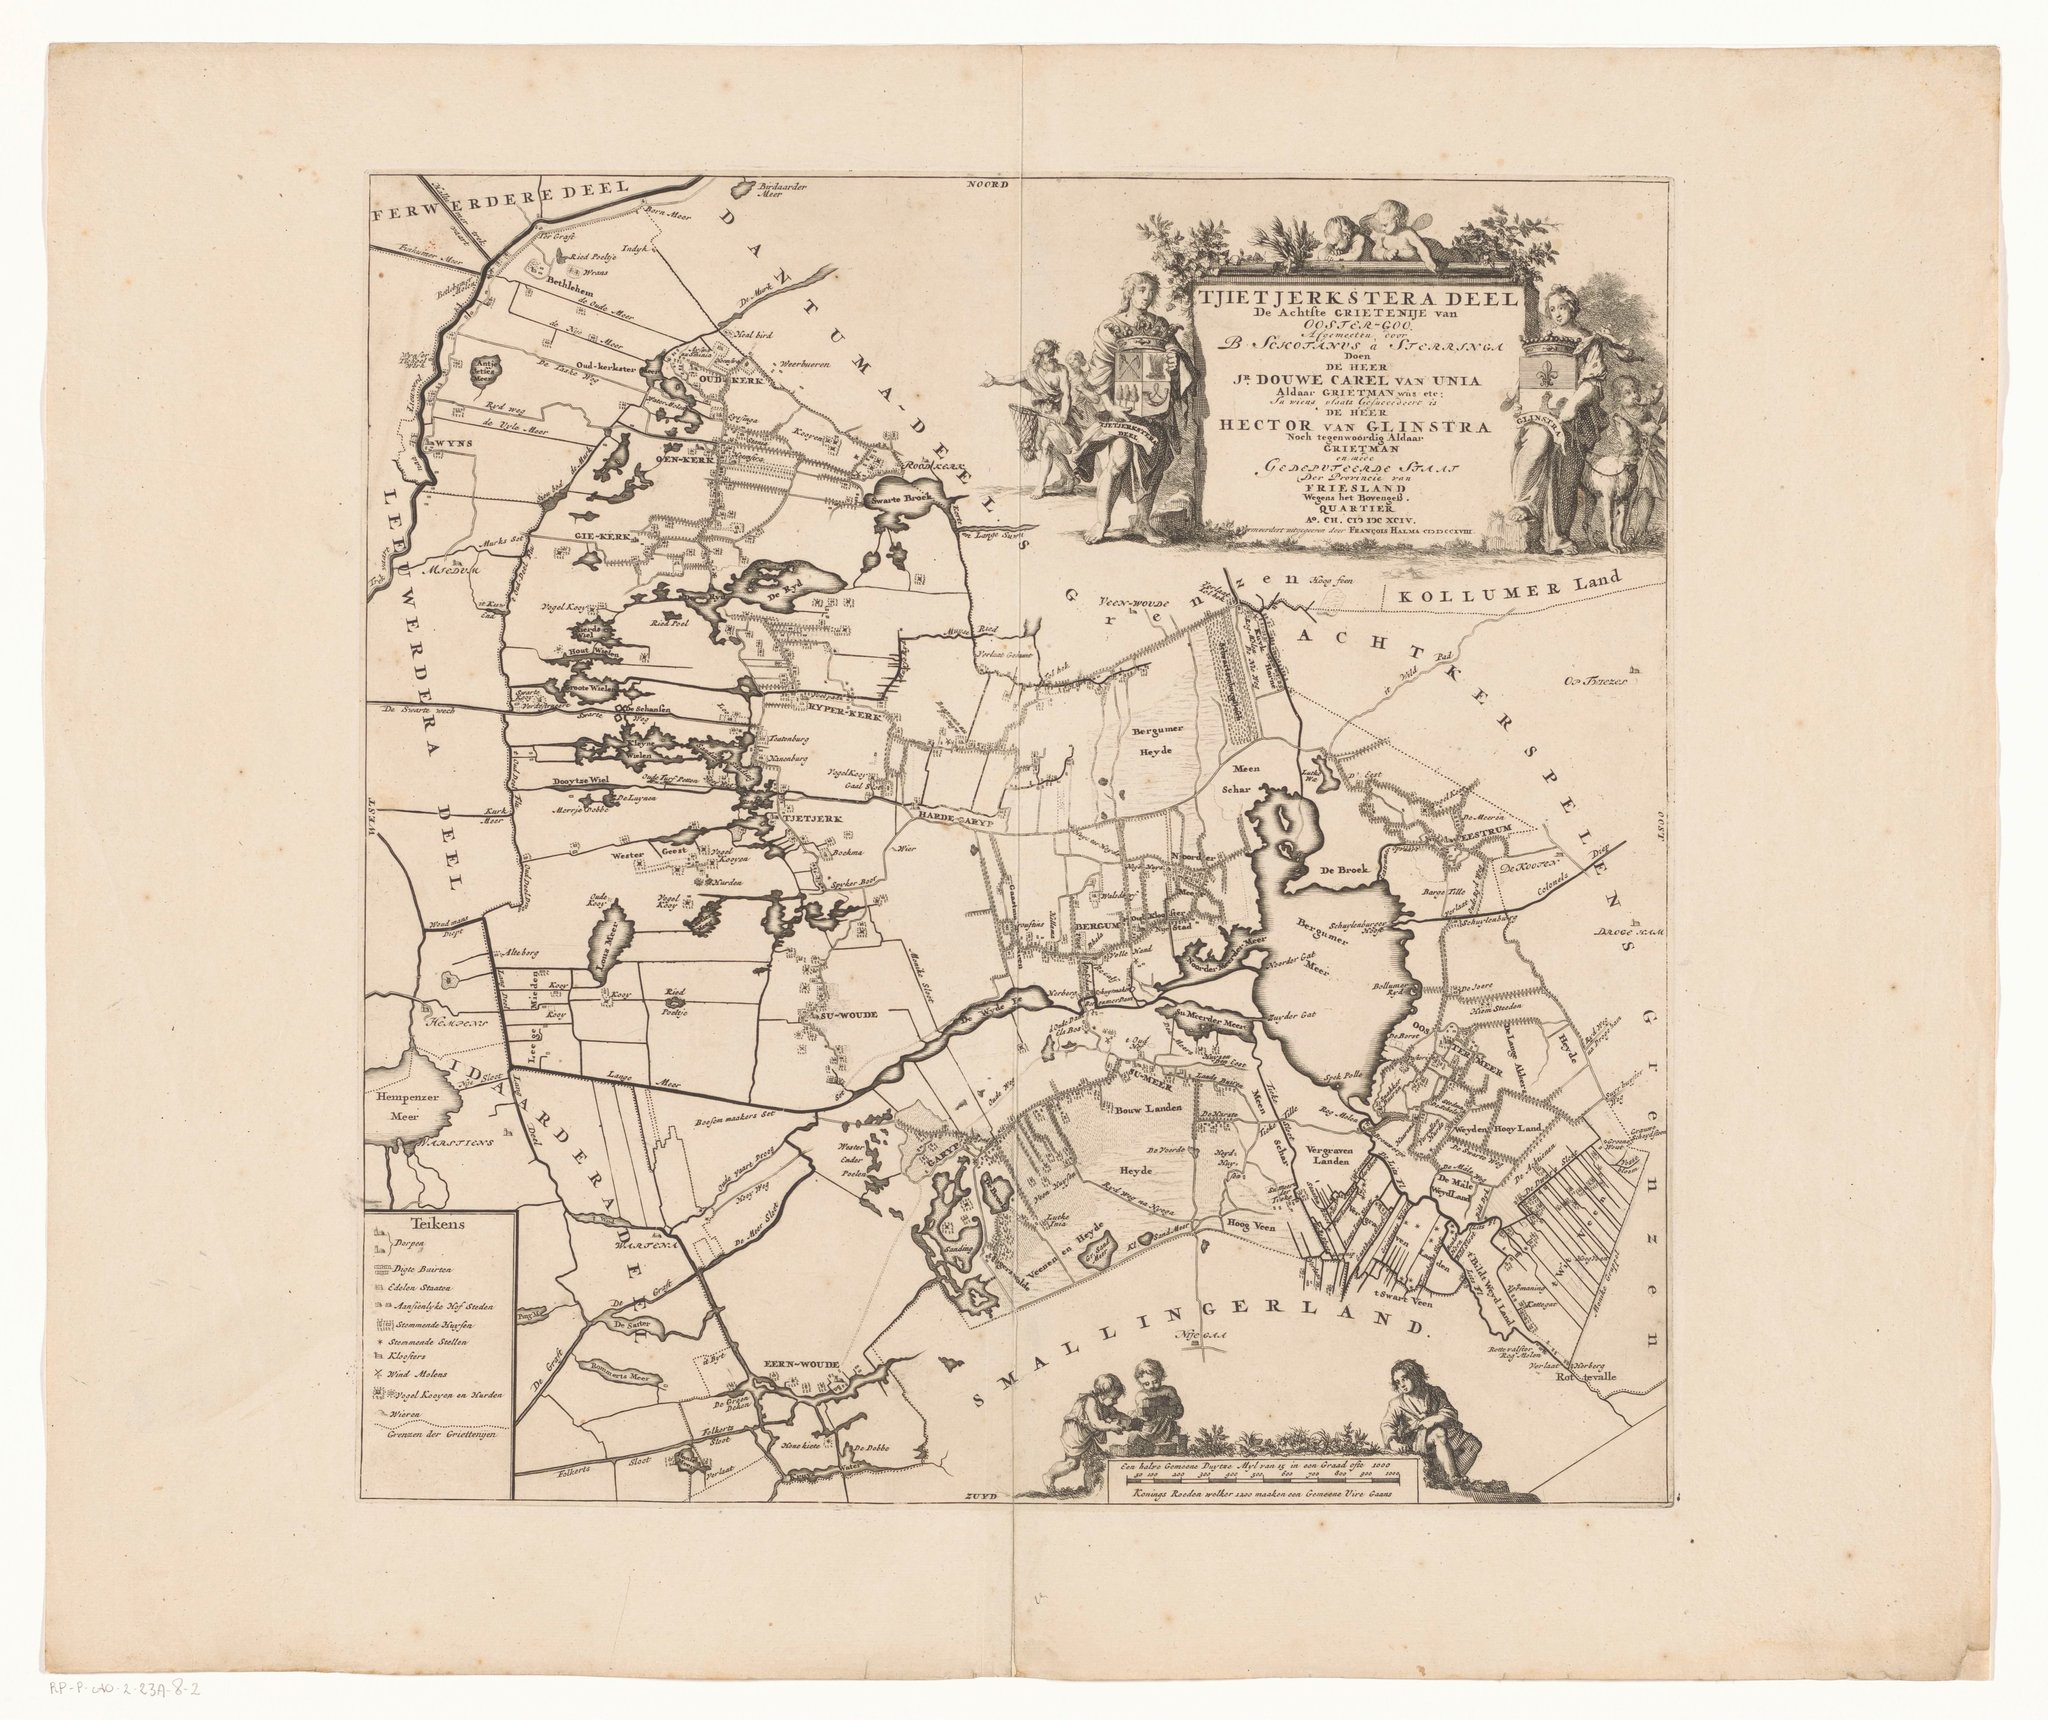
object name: print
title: Kaart van de grietenij Tietjerksteradeel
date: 1698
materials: paper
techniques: engraving, etching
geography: leeuwarden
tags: peat (soil type), coat of arms (as symbol of the state, etc.), maps of separate countries or regions, hunting, chase, fishing (sports)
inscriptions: collector's mark: Lugt 19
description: Linksonder legenda. Rechtsboven cartouche met titel en bestuurlijke informatie over de grietenij. Daaromheen een visser, een man met het wapen van Tietjerksteradeel, twee putti, een vrouw met het wapen van grietman Hector van Glinstra en een jongen met een jachthoorn en -hond. Rechtsonder een schaalstok: Een halve gemeene Duytze myl van 15 in een graad ofte 1000 konings roeden welker 1200 maaken een gemeene uire gaans. Daaromheen drie jongens waarvan twee turf stapelen.